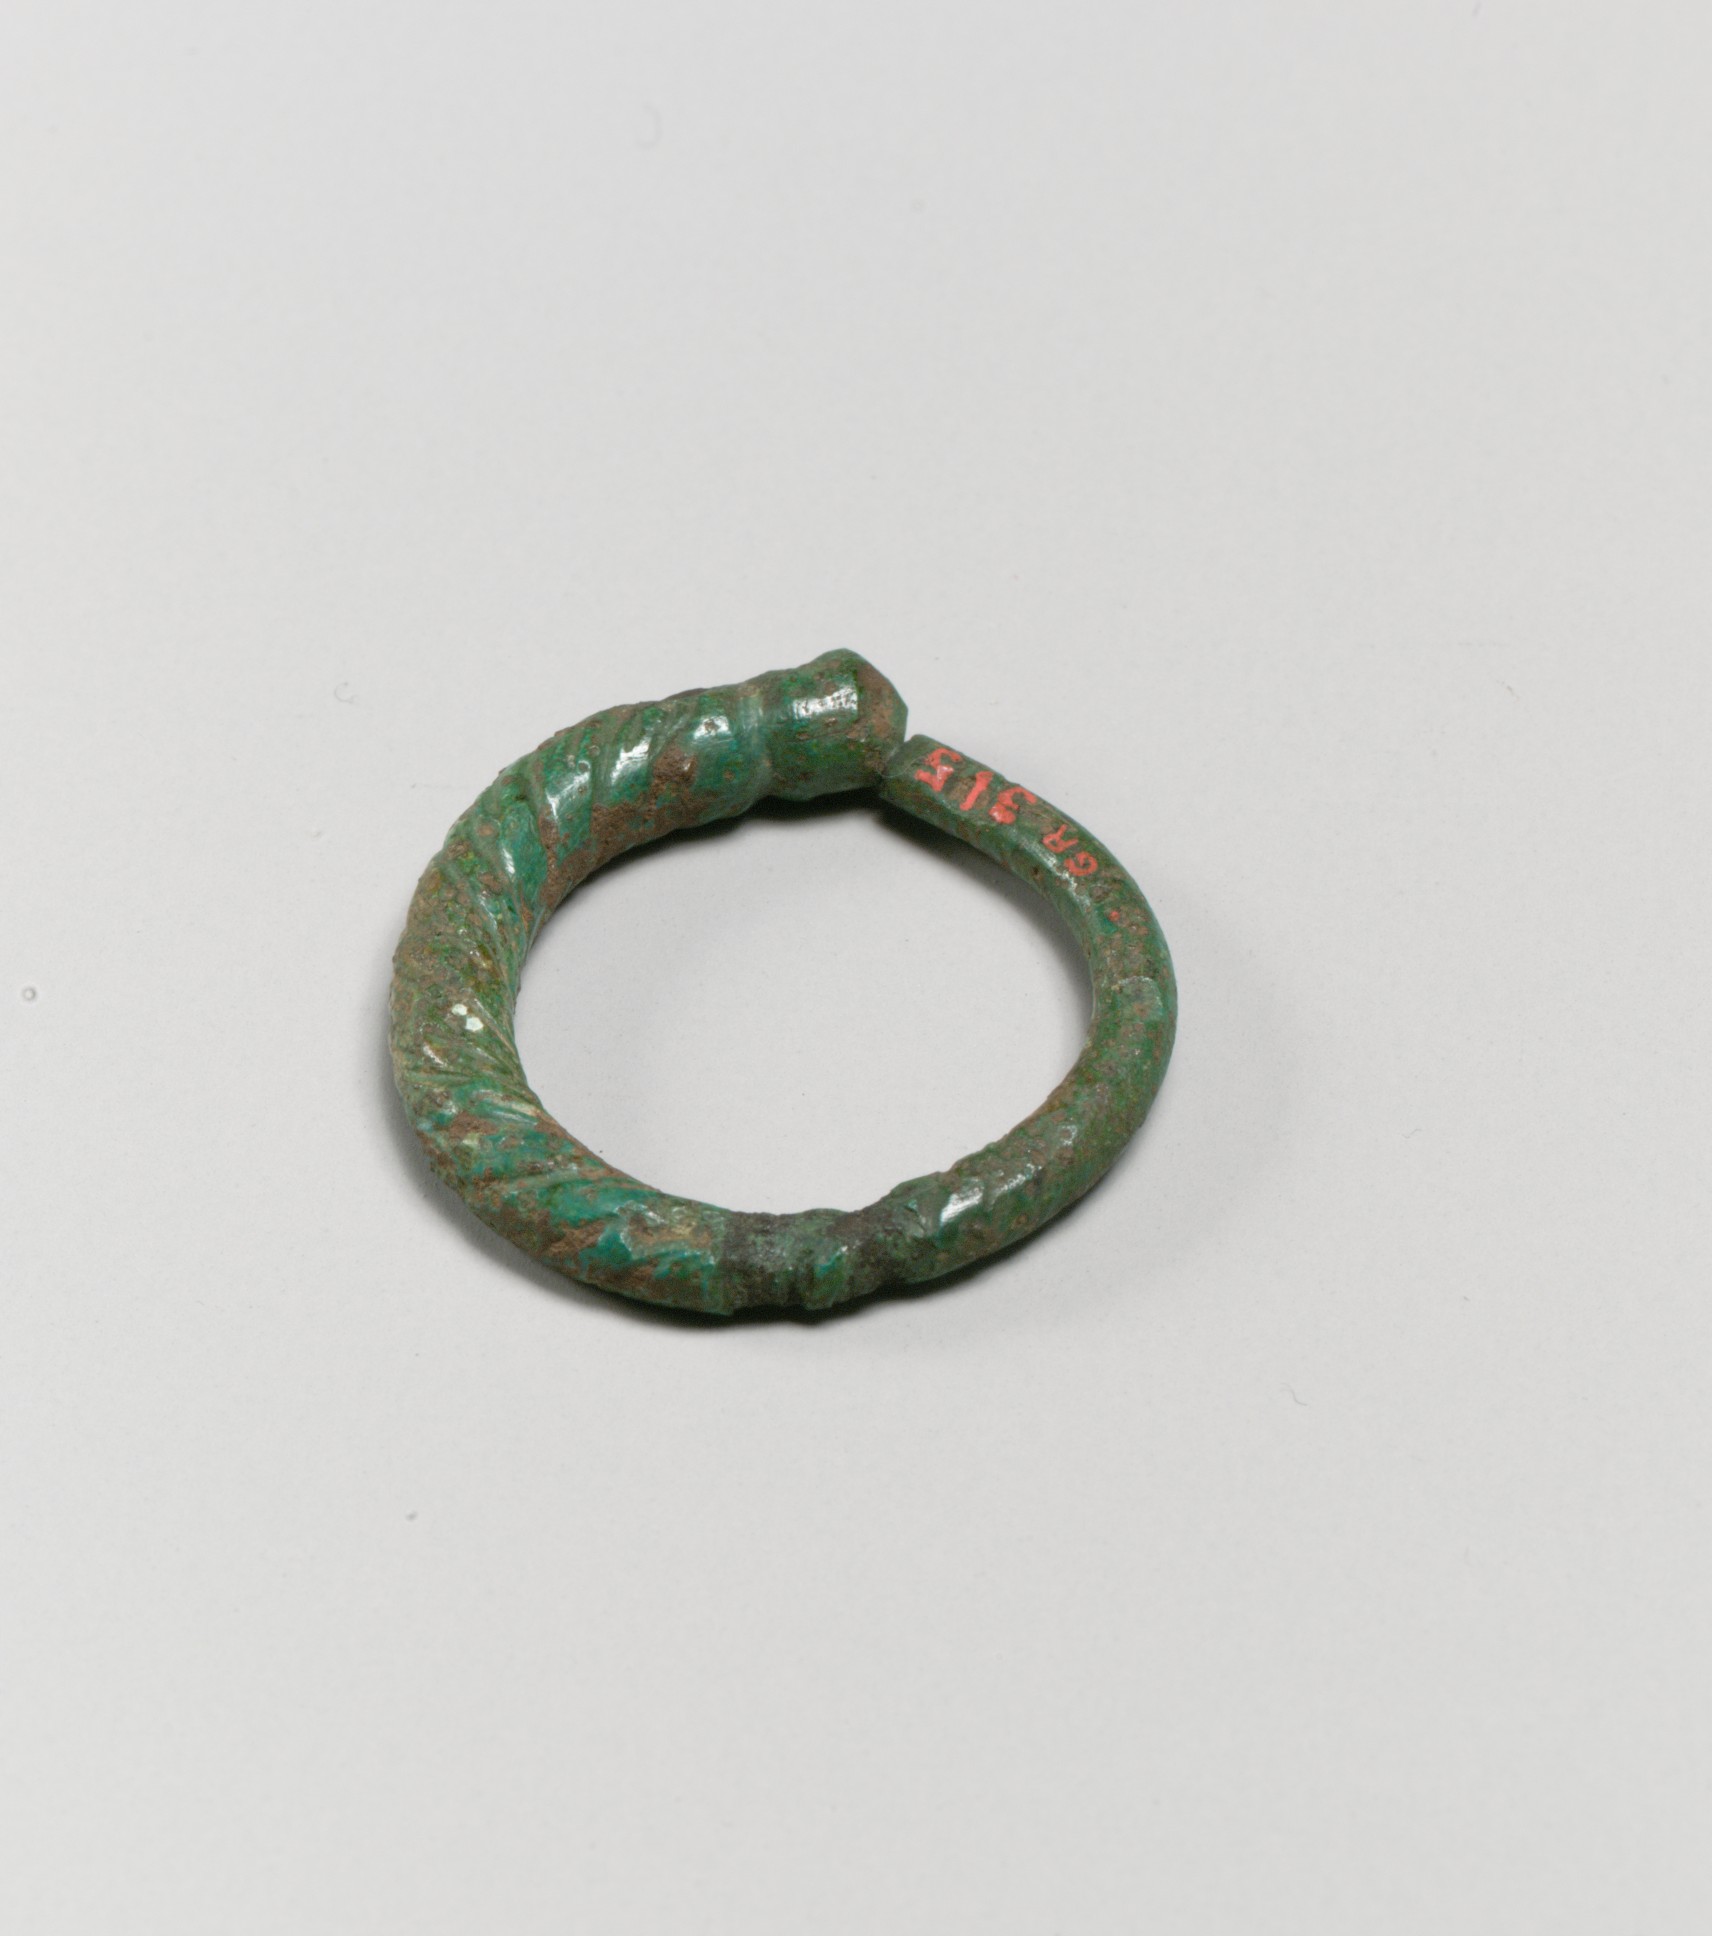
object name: ring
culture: etruscan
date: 600-201 BCE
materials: bronze